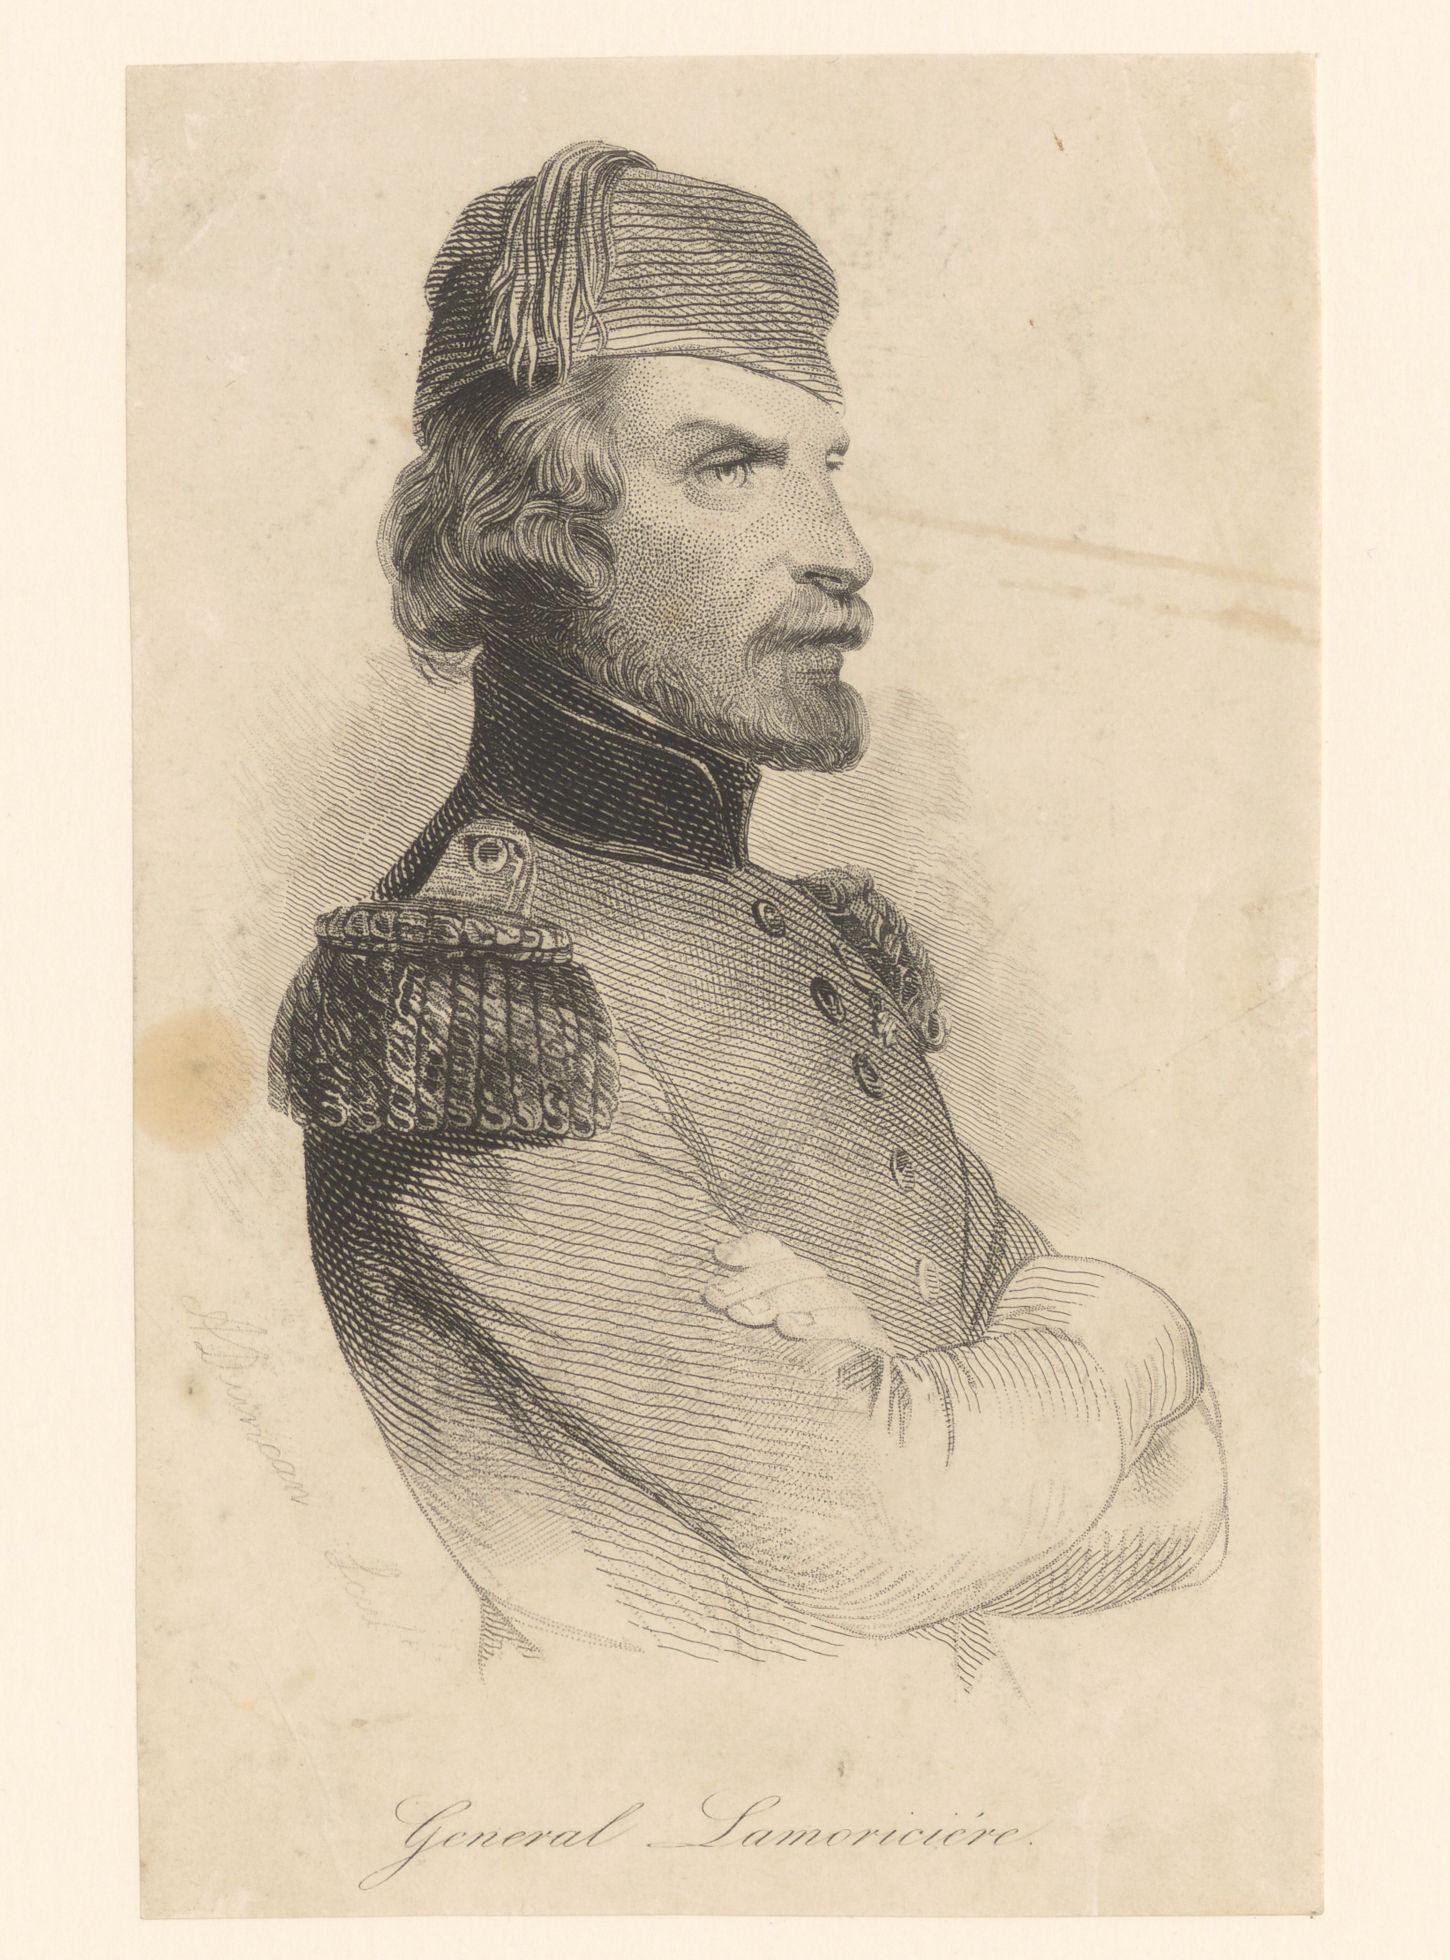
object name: print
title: Portret van Christophe Léon Louis Juchault de Lamoricière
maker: andrew duncan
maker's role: print maker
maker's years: 1795-1855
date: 1830-1895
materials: paper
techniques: engraving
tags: commander-in-chief, general, marshal, historical persons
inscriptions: collector's mark: Lugt 2228